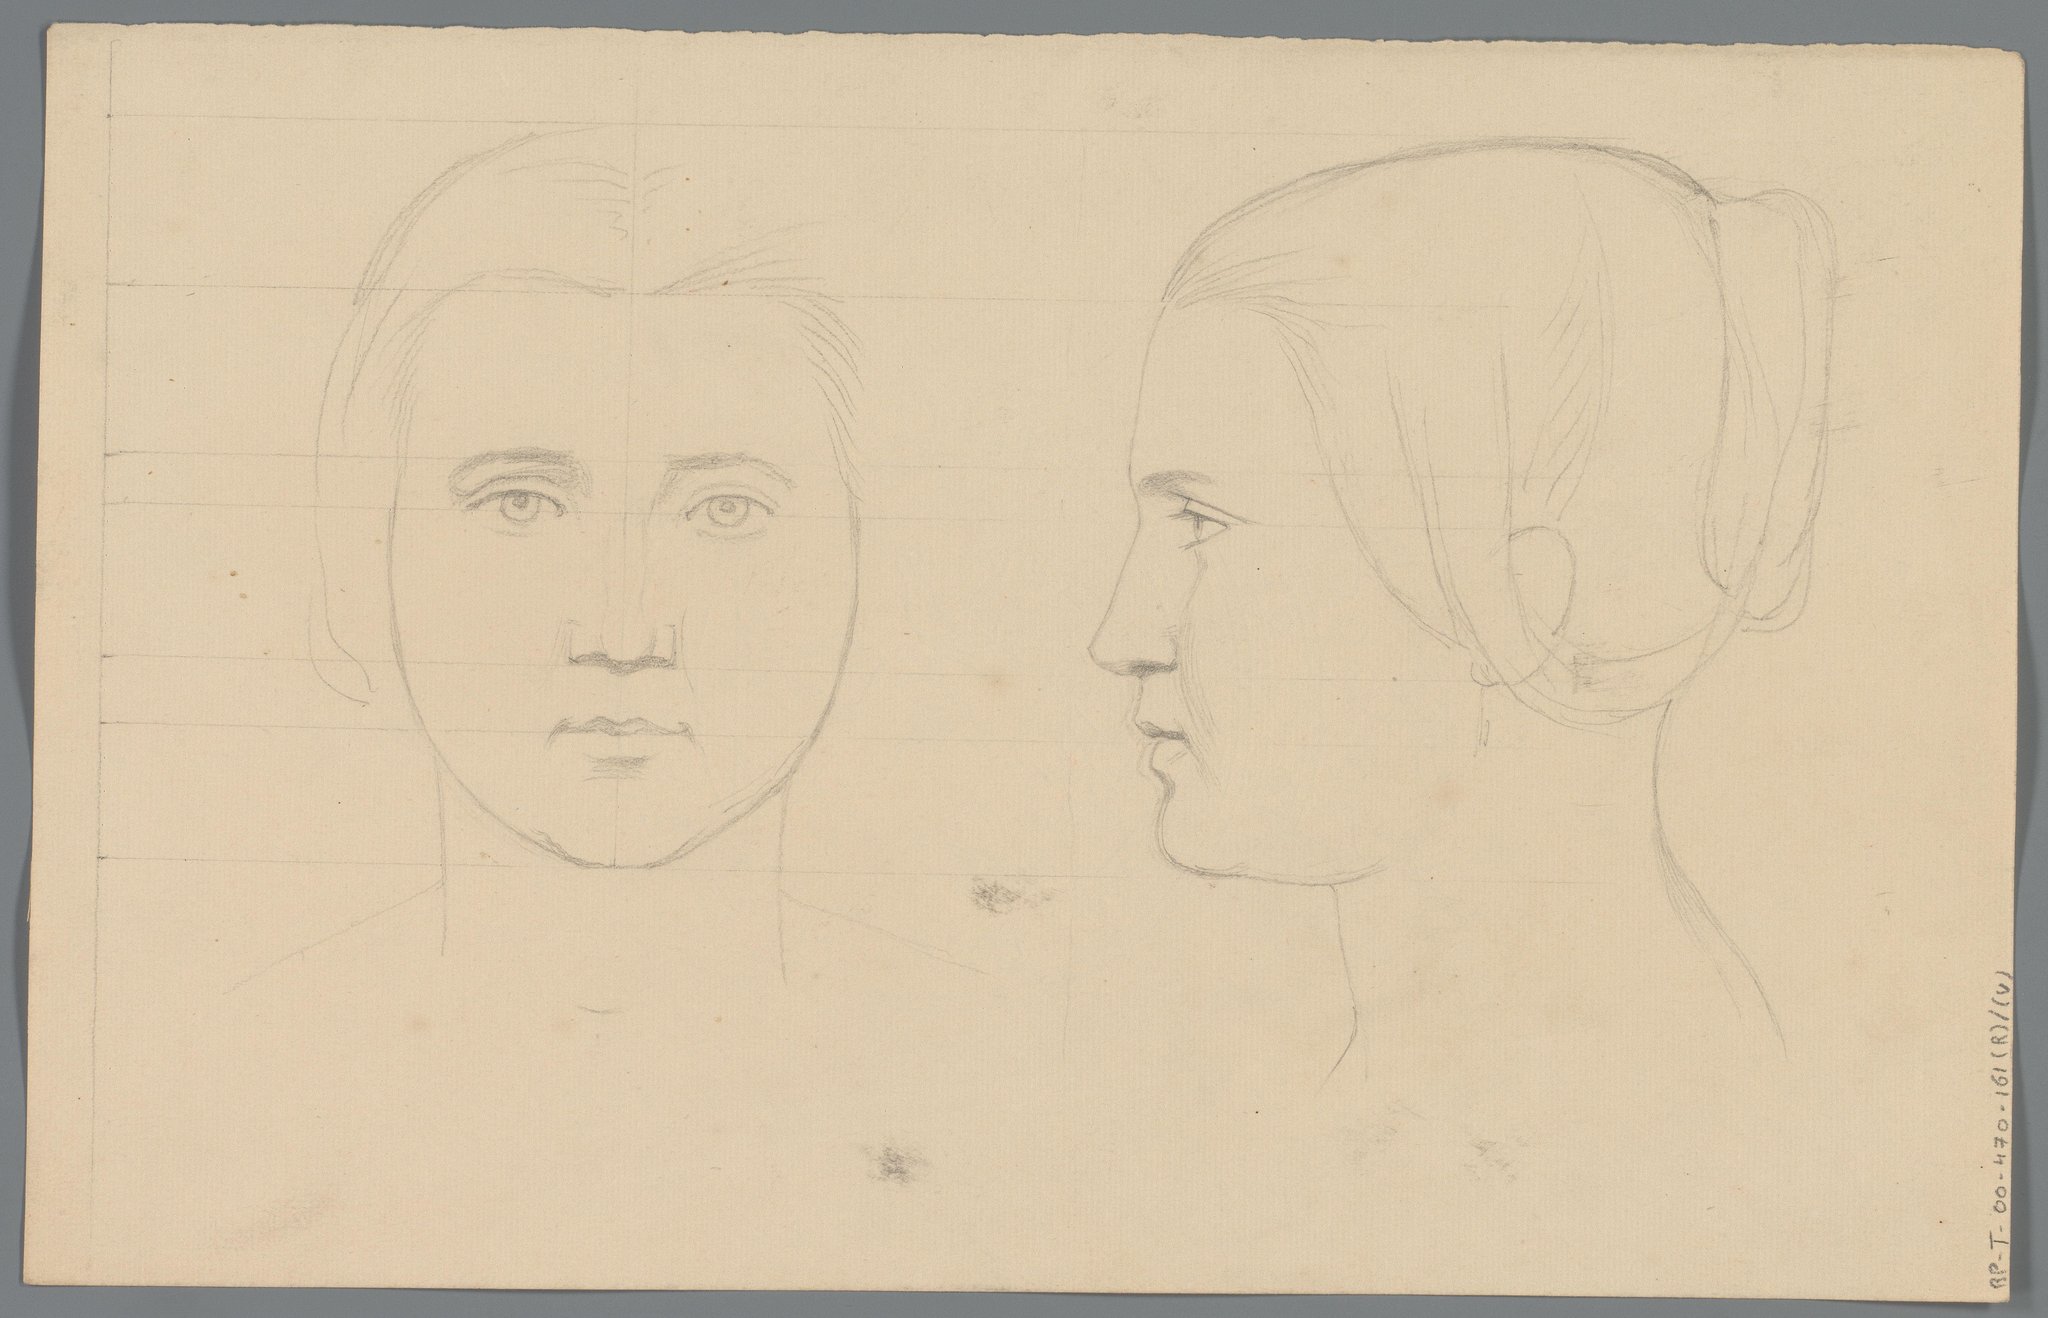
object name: drawing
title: Studie van een vrouwengezicht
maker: jacobus everhardus josephus van den berg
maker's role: draughtsman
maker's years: 1802-1861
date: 1812-1861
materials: paper, pencil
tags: face